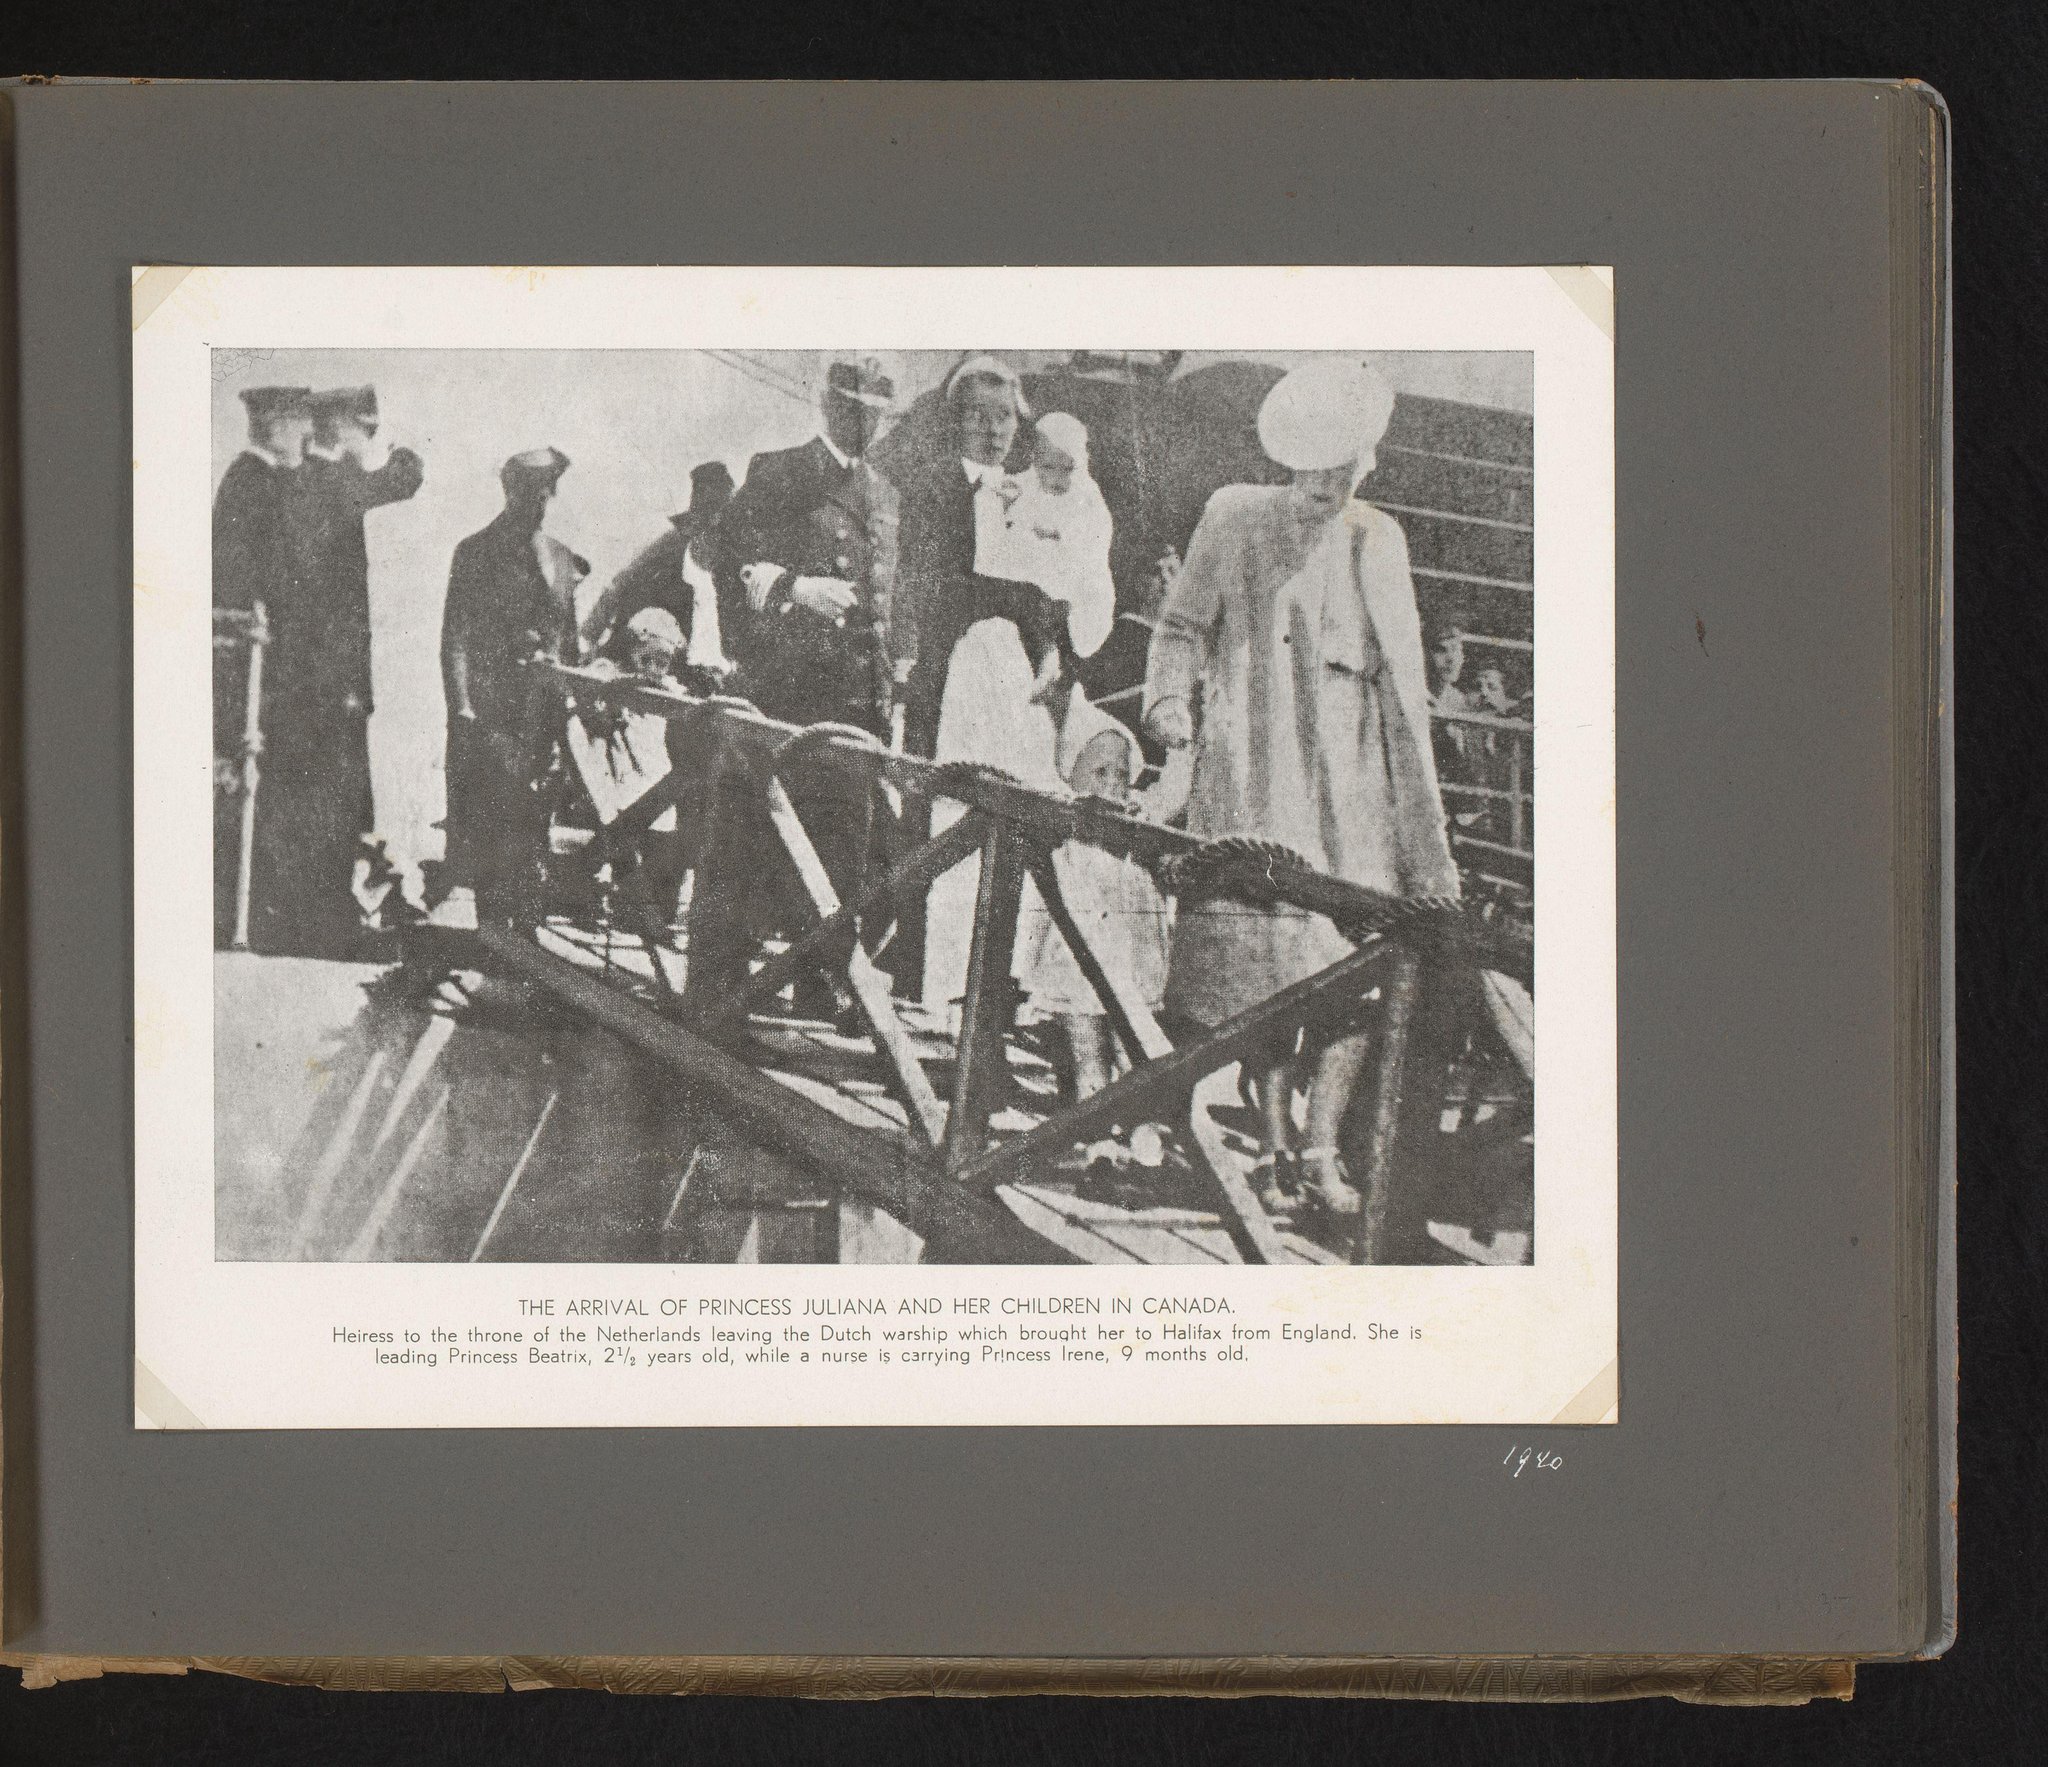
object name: album leaf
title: The arrival of Princess Juliana and her children in Canada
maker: Anonymous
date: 1940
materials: cardboard, paper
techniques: screen printed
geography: canada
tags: beatrix (koningin der nederlanden), juliana of the netherlands, parents with their children, canada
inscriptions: inscription: ‘1940’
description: Albumblad met reproductie van een foto van de aankomst in Canada van prinses Juliana met de prinsessen Beatrix en Irene, 1940. Onderdeel van fotoalbum over het familieleven van de leden van het Koninklijk Huis tussen 1937-1945.